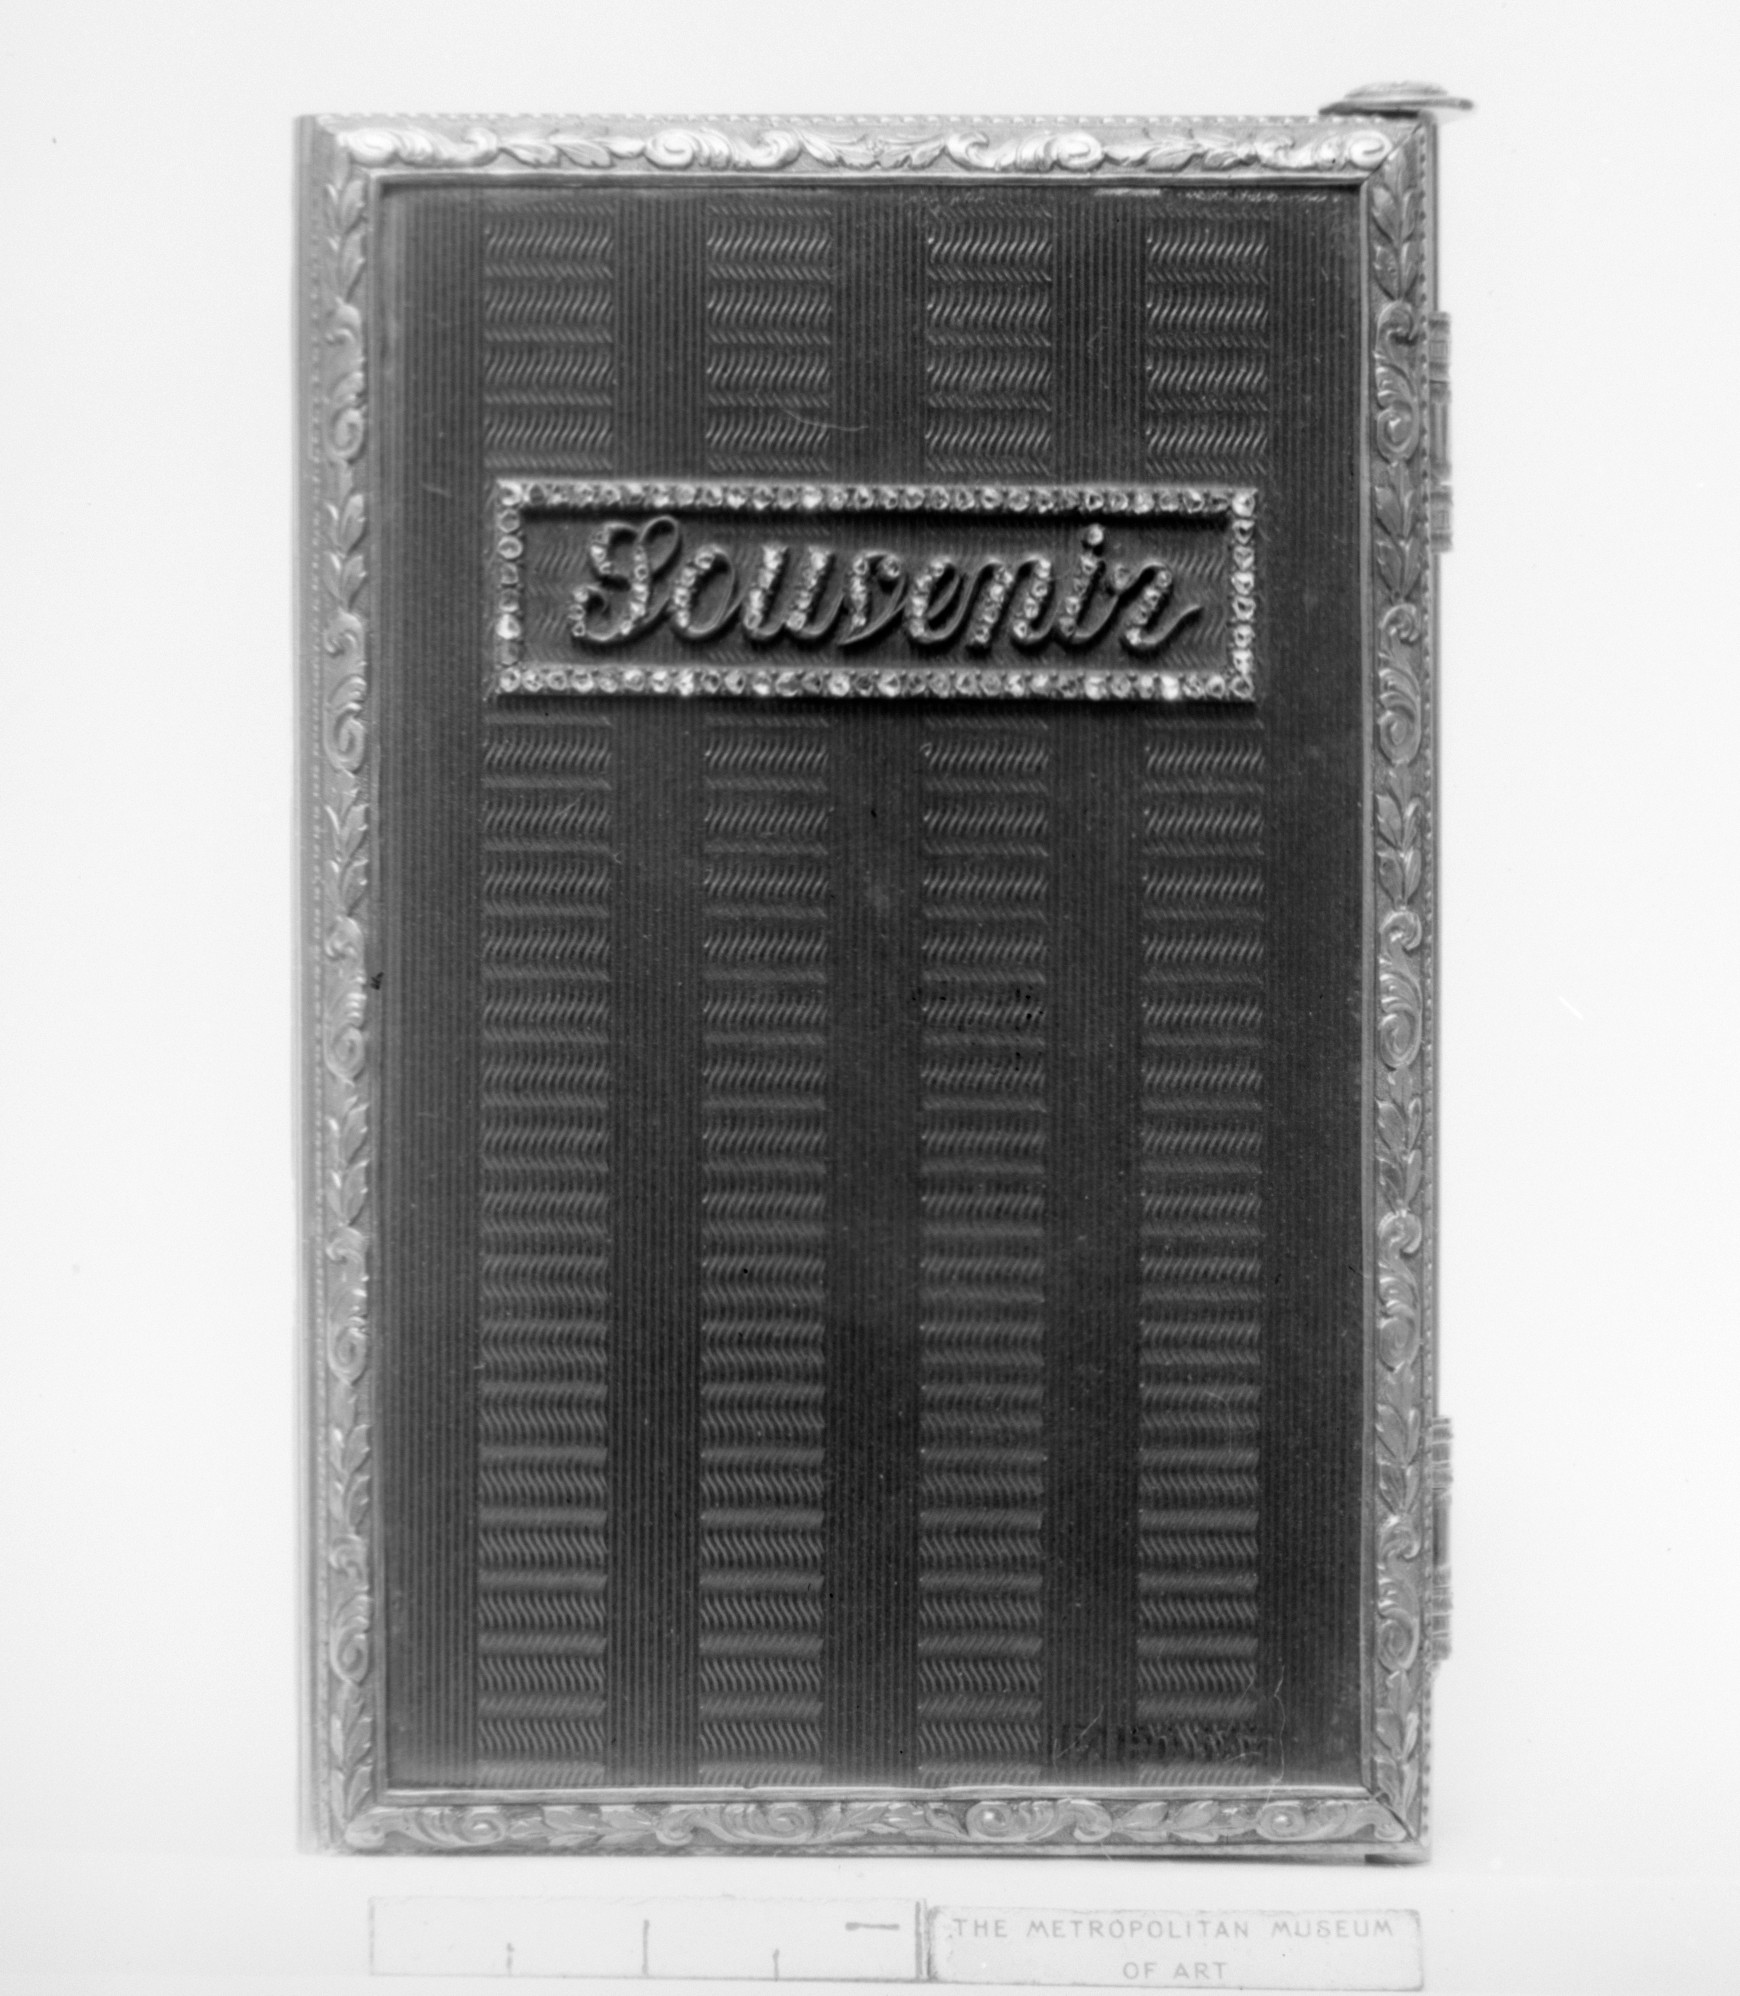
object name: souvenir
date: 1801-1900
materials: diamond, enamel, gold